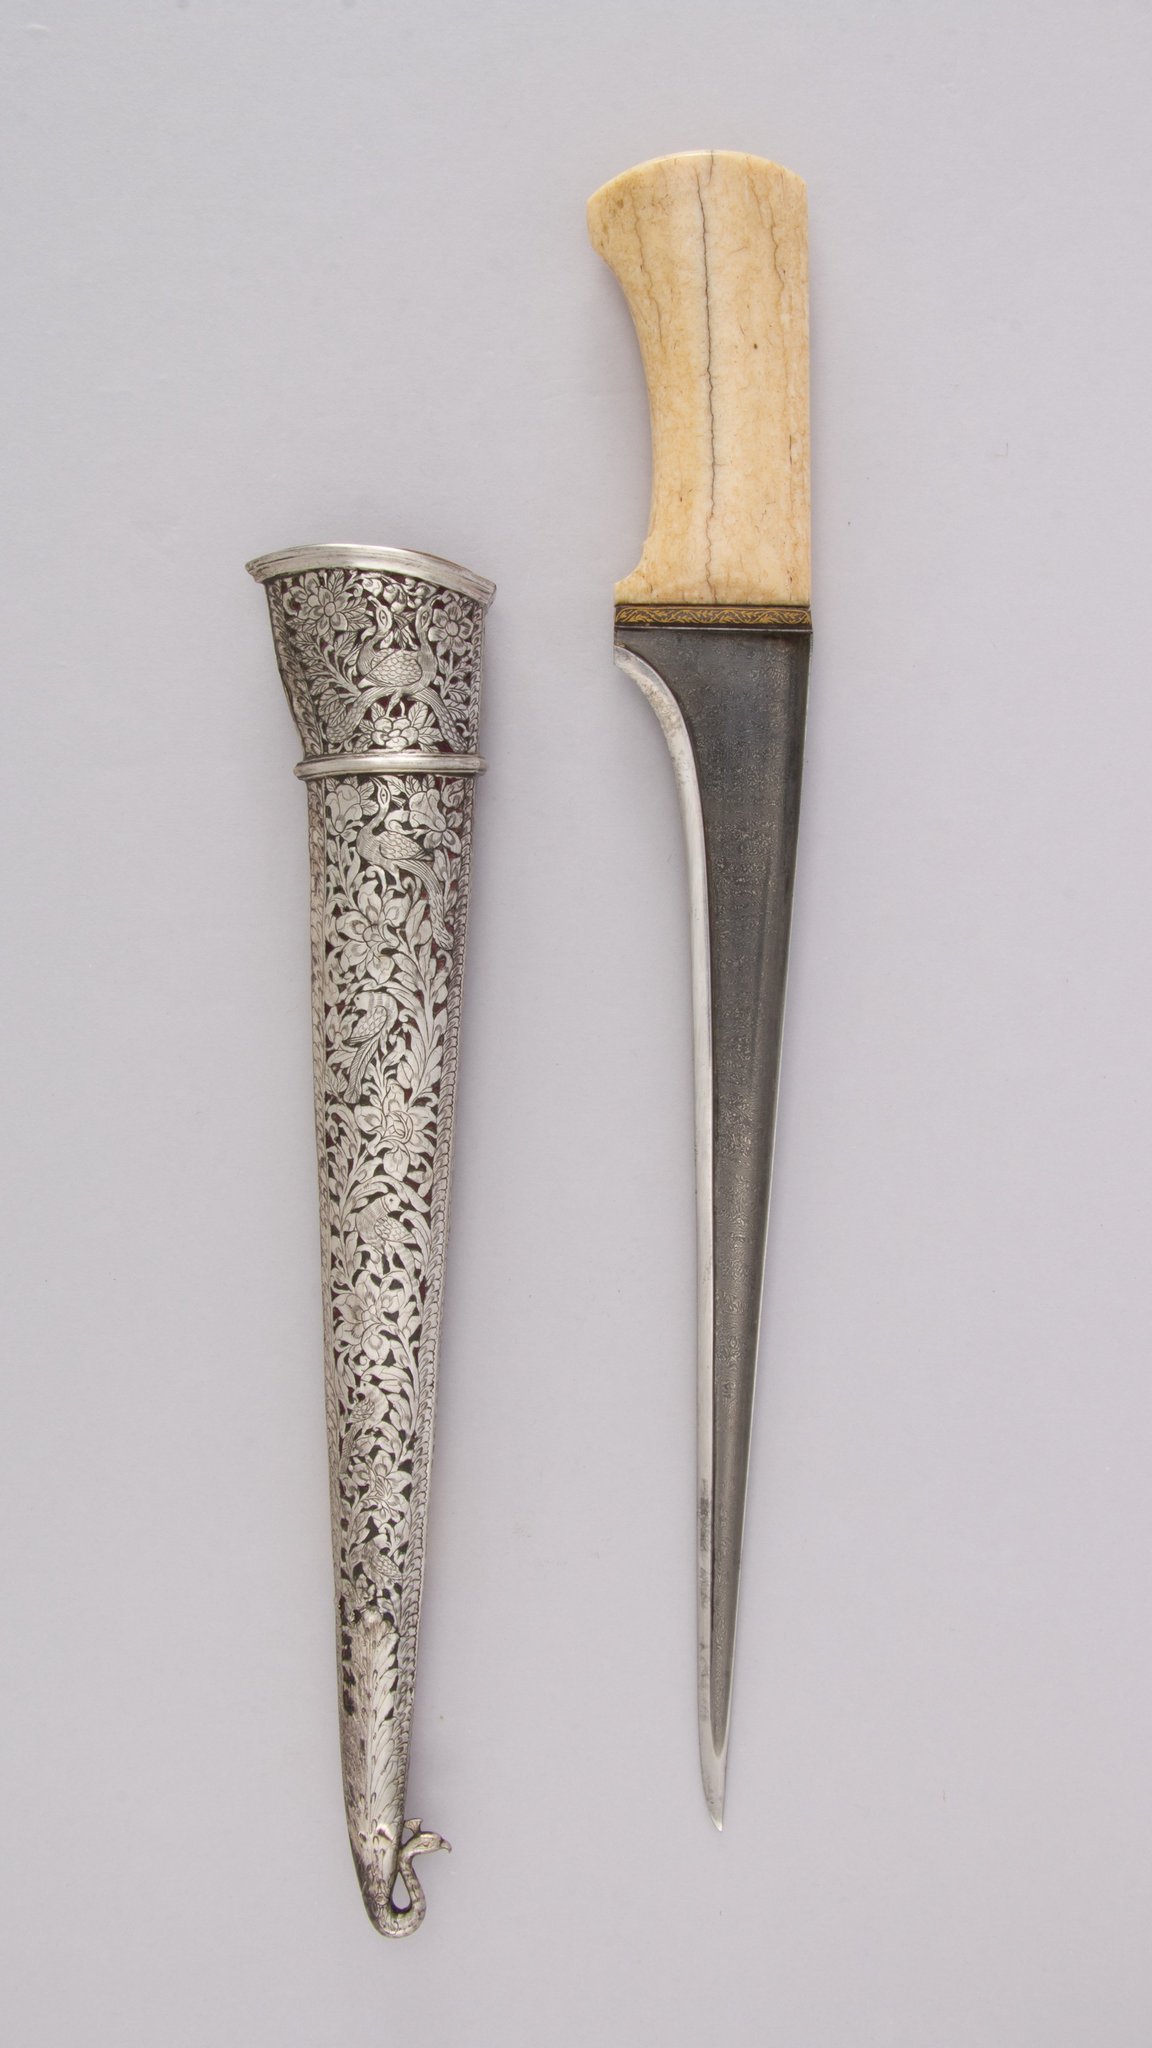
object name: dagger pesh kabz with sheath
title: Dagger (Pesh-kabz) with Sheath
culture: south indian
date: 1701-1900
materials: gold, ivory, silver, steel, wood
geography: india